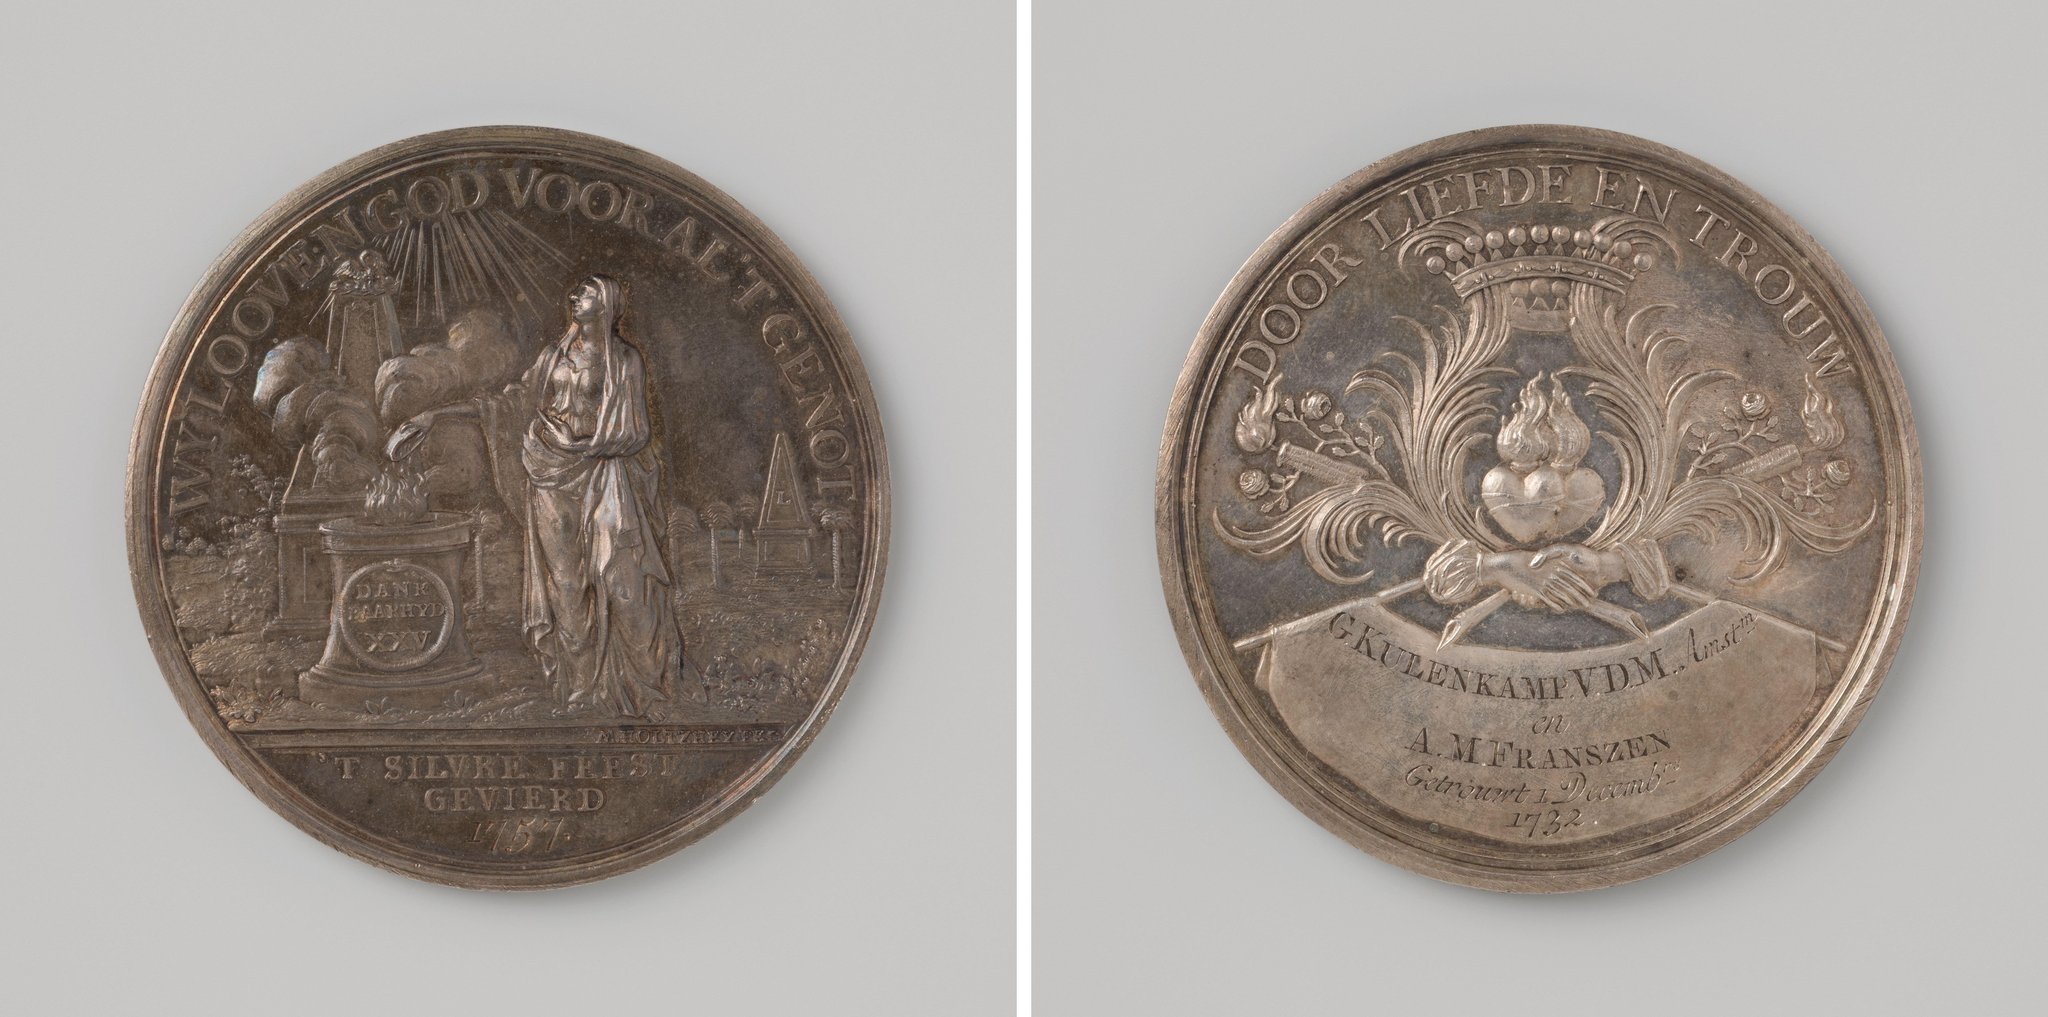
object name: history medal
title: Zilveren huwelijk van G. Kulenburg en A.M. Franszen (algemene huwelijkspenning met inscriptie) 1757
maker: martinus holtzhey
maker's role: medailleur, muntmaker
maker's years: 1697-1764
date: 1757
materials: silver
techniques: engraving, striking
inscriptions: inscription: ‘G. KULENKAMP. V.D.M. Amstm. / en / A.M. FRANSZEN / Getrouwd 1 Decembrs. / 1752.’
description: Zilveren penning, op de voorzijde een gesluierde vrouw offerend boven een altaar waarop DANK / BAARHEID / XXV binnen een slangenrond, in een landschap met twee monumenten, met omschrift, in de afsnede 'T SILVERE FEEST / GEVIERD waaronder gegraveerd "1757", op de keerzijde twee brandende harten onder een kroon tussen liefdessymbolen, met omschrift, onderaan een doek met inscriptie.